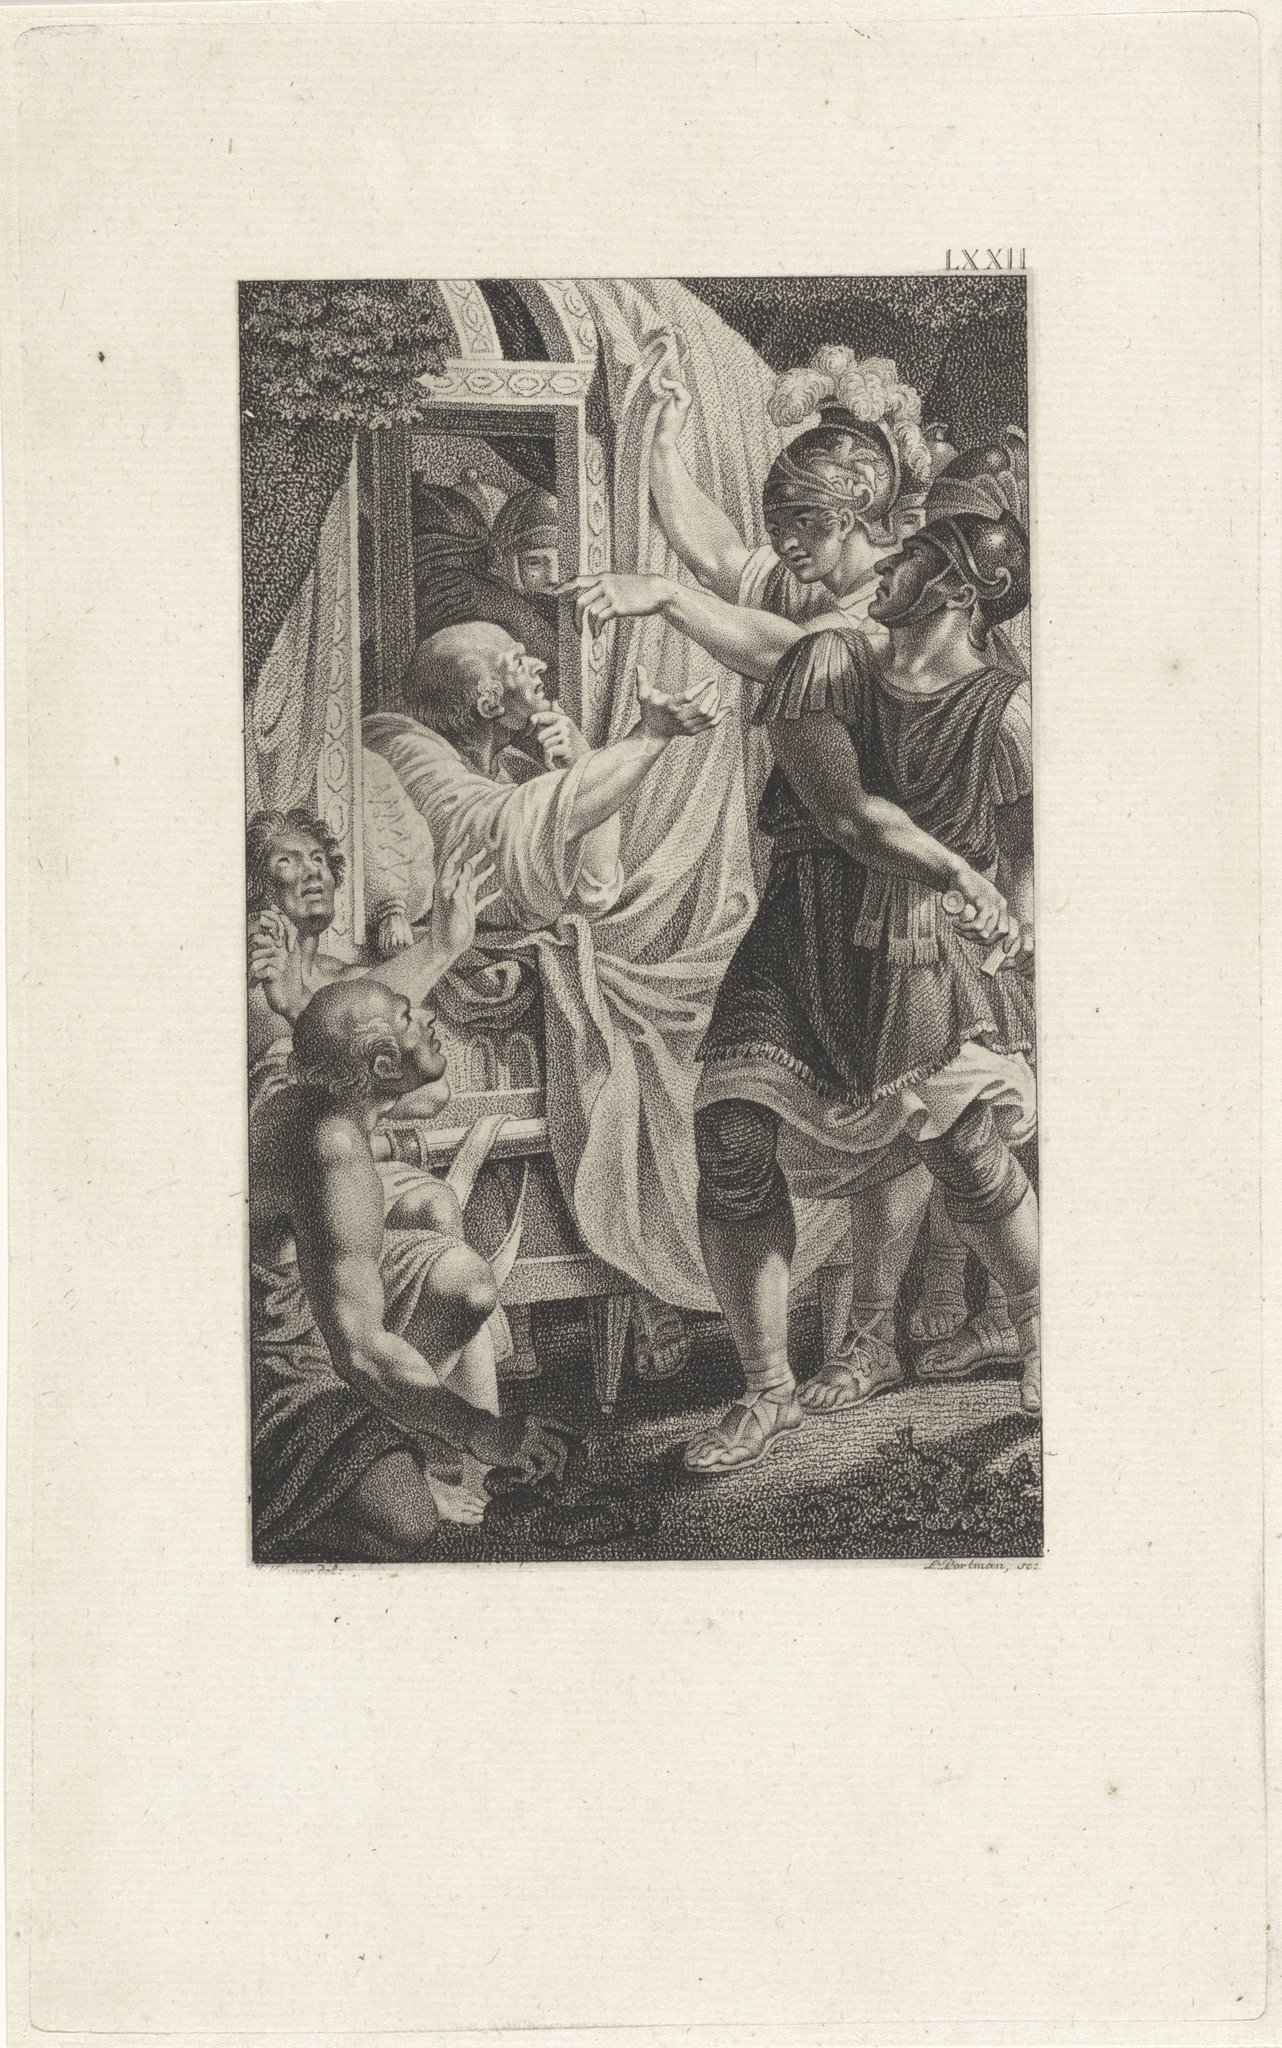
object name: book illustration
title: Dood van Cicero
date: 1801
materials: paper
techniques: etching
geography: amsterdam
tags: death of cicero: he is slain by soldiers at the order of the triumvirs, slavery; serfs and enslaved persons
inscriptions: collector's mark: Lugt 2228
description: Cicero zit in zijn draagbaar en steekt zijn hoofd naar buiten, met zijn linkerhand raakt hij zijn kin aan. Hij heeft zijn slaafgemaakten opgedragen hem aan zijn lot over te laten. Cicero wordt aangevallen door Herennius, die hem op bevel van het triumviraat met zijn zwaard zal onthoofden.